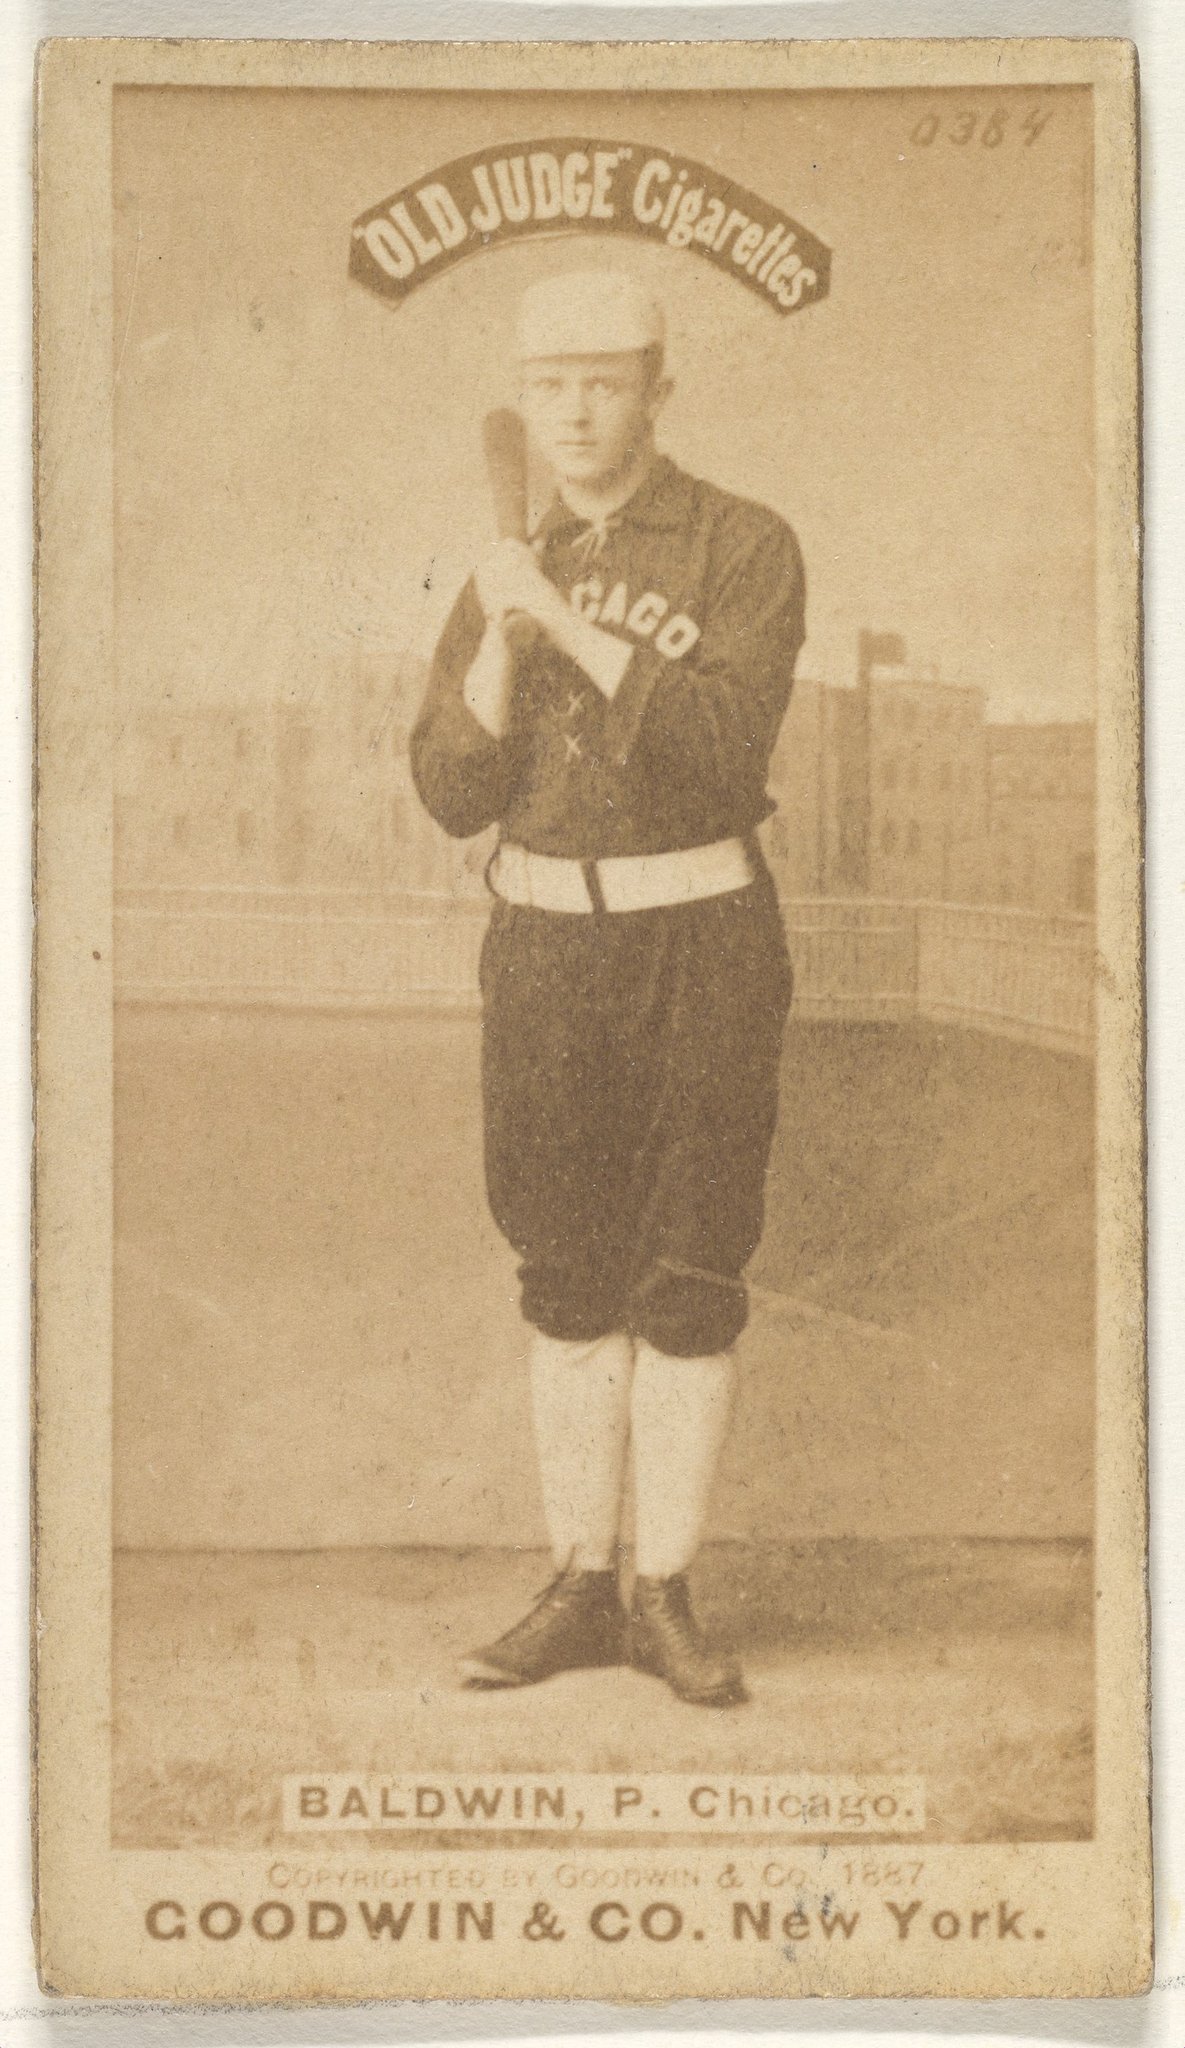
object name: baseball card, photograph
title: Baldwin, Pitcher, Chicago, from the Old Judge series (N172) for Old Judge Cigarettes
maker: goodwin & company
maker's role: publisher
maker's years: 1850-1950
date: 1887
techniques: albumen silver print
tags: men,portraits,baseball,athletes